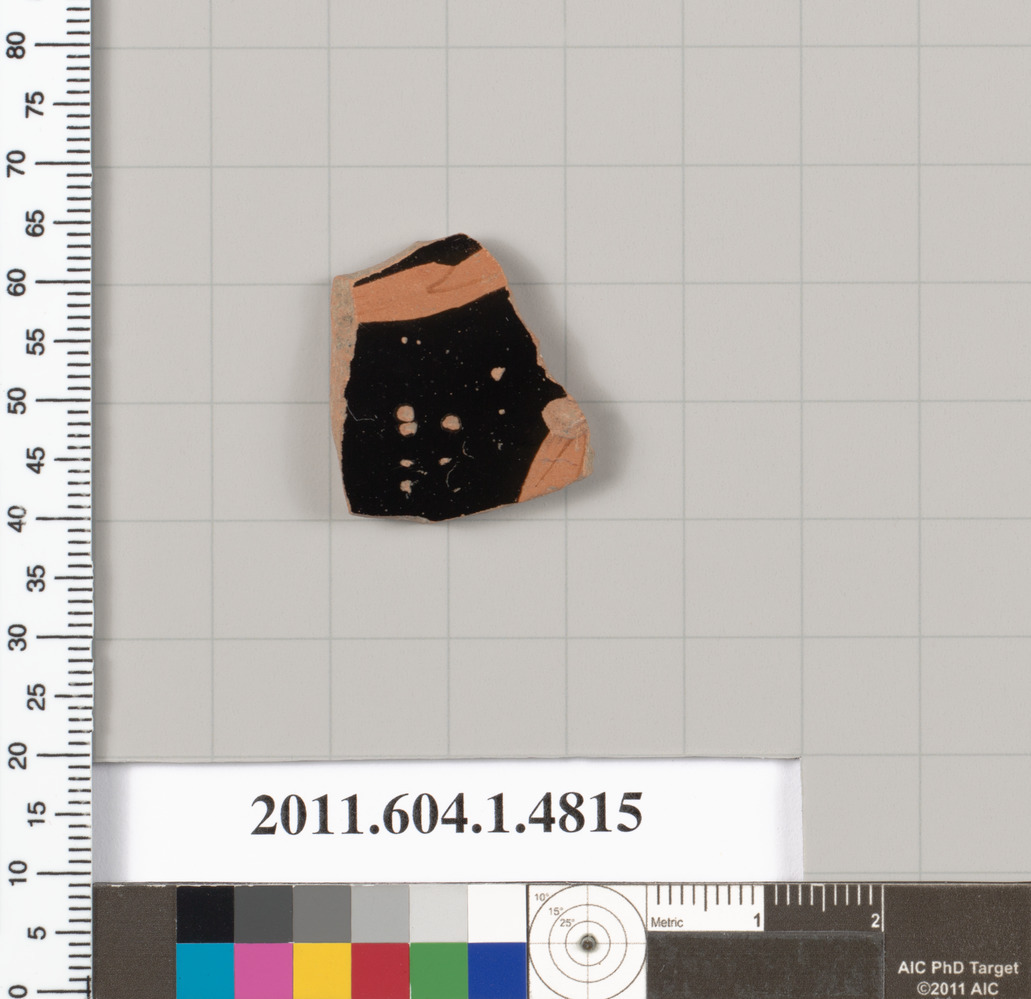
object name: kylix fragment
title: Terracotta fragment of a kylix (drinking cup)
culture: greek, attic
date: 475-451 BCE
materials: terracotta